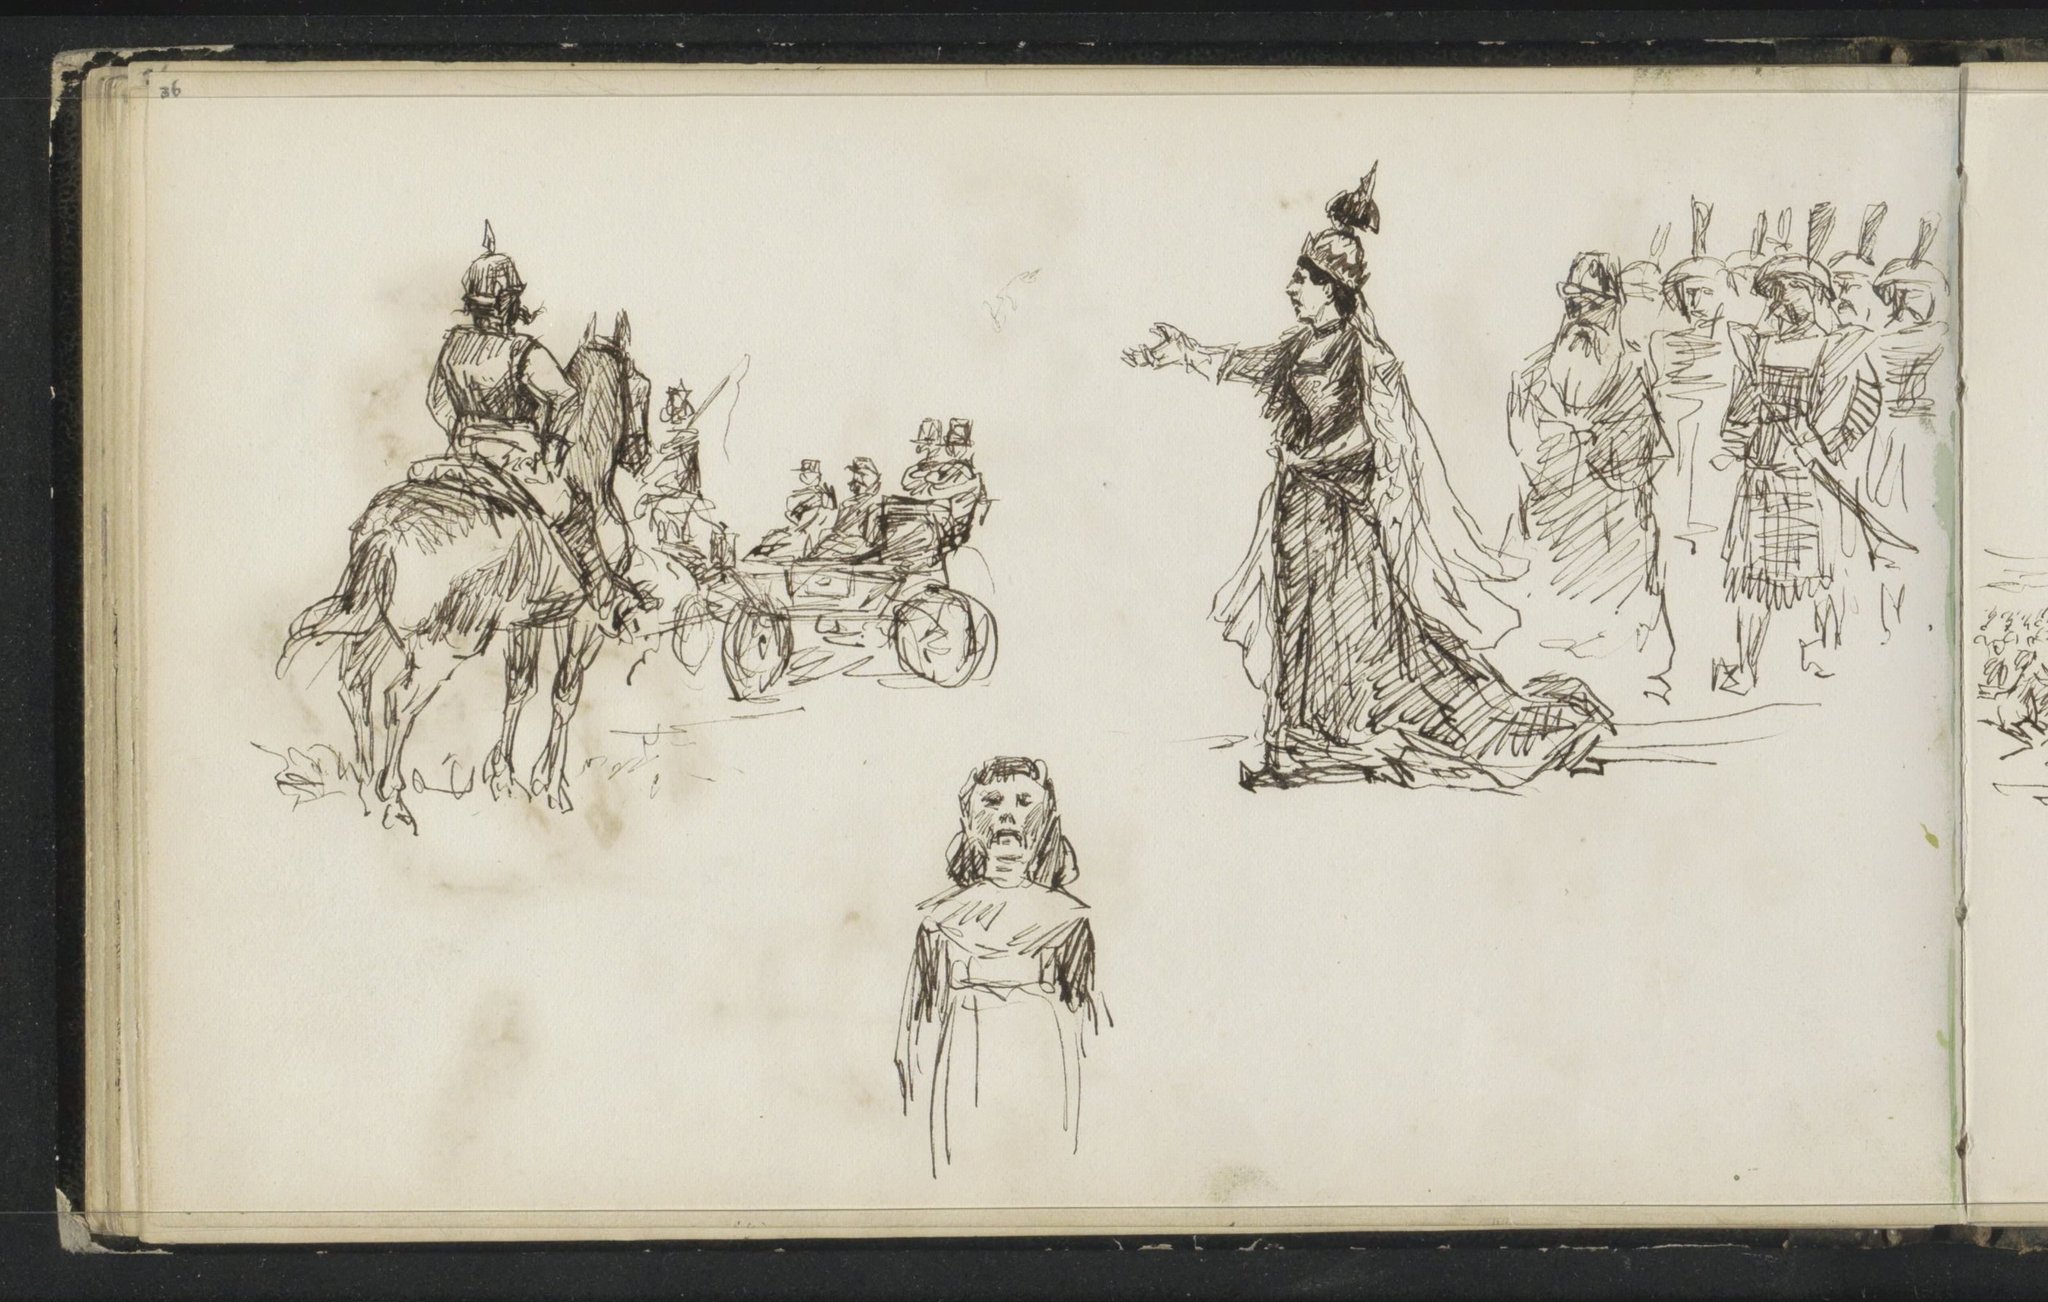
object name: sketchbook leaf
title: Studieblad, onder andere met een militair te paard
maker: marius bauer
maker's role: draughtsman, print maker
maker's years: 1867-1932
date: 1812-1880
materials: paper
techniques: pen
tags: riding a horse, ass, or mule; rider, horseman, crown (symbol of sovereignty), standing figure, adult woman, (military) uniforms, arm stretched forward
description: Tevens een studie van een groep soldaten geschaard achter een vrouwfiguur met uitgestoken arm en een kroon. Pagina 36 uit een schetsboek met 34 bladen.